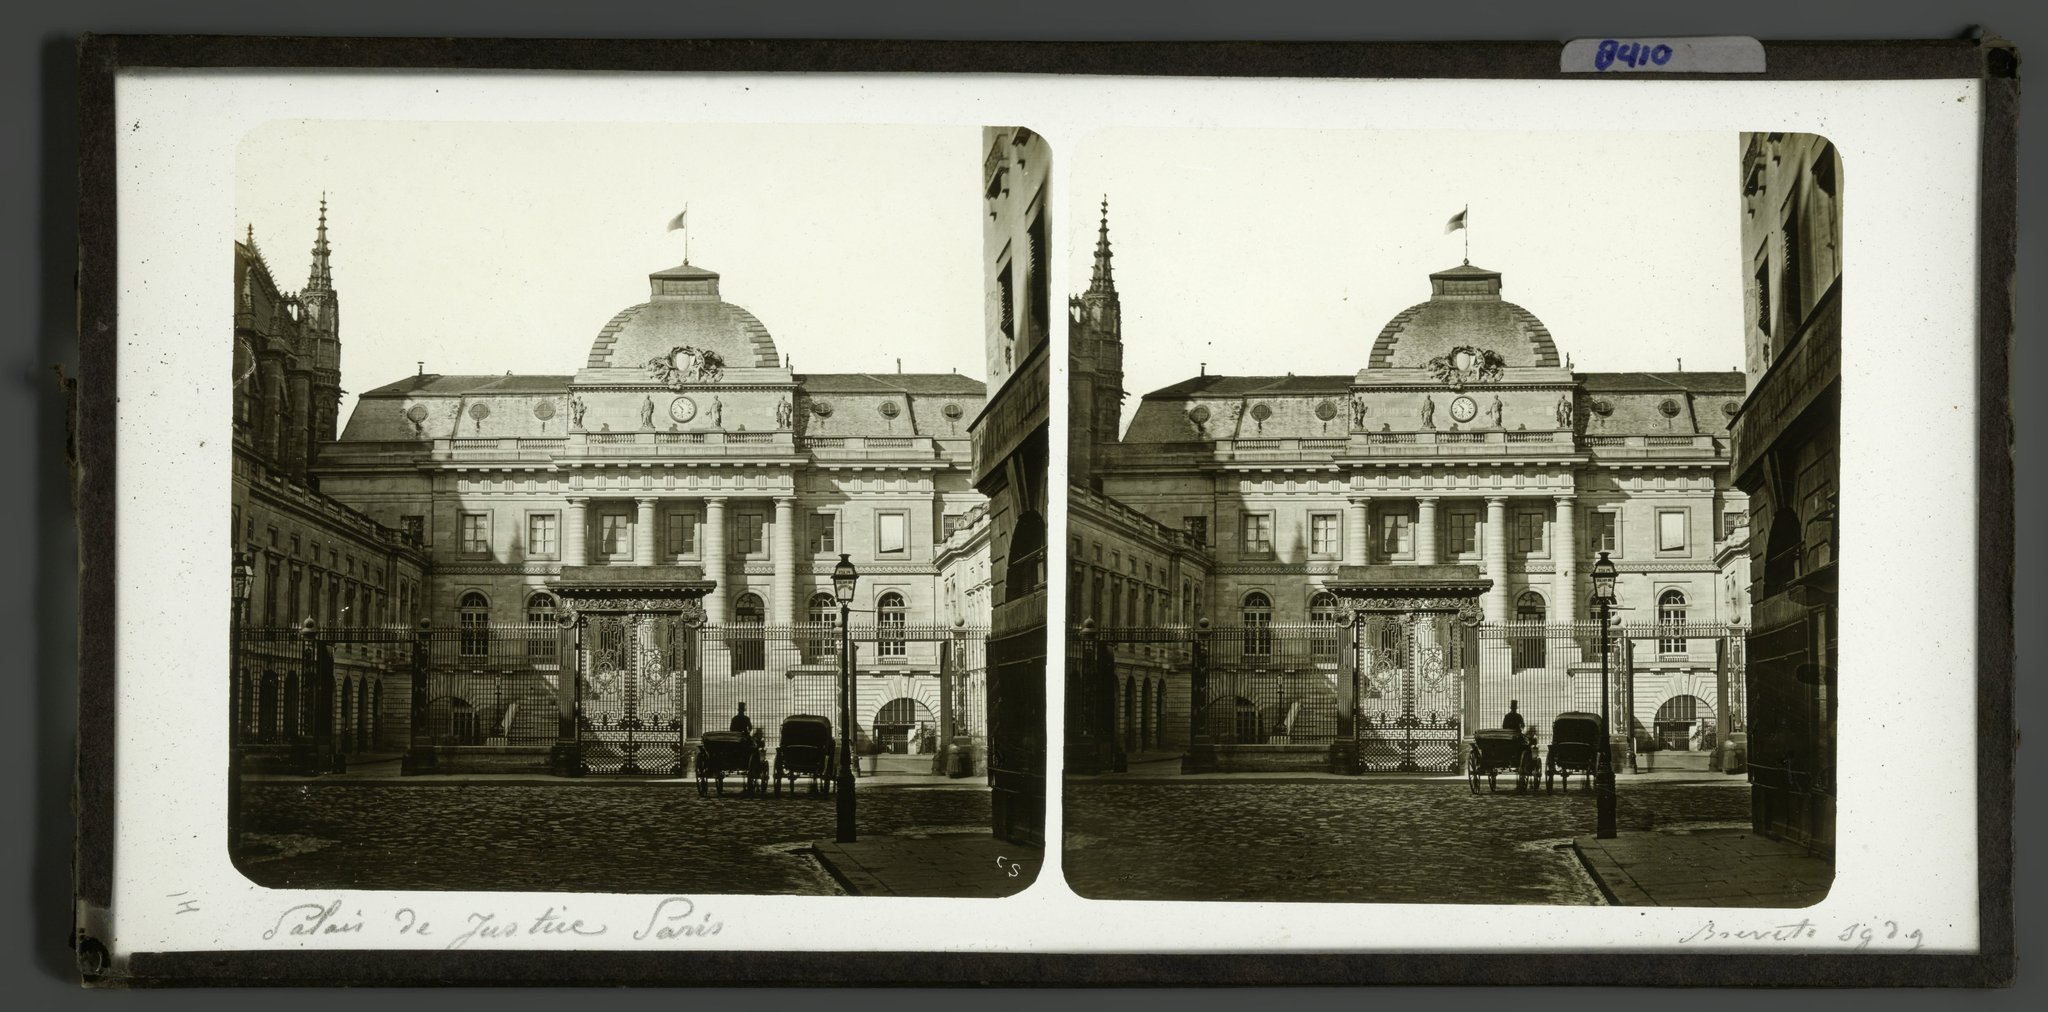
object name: stereoscopic photograph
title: Gezicht op het Palais de Justice in Parijs, Frankrijk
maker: charles segoffin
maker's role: fotograaf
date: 1856-1890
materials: glass, paper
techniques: slide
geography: paris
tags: court building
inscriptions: annotation: ‘14 Palais de Justice Paris Brevete sgdg’